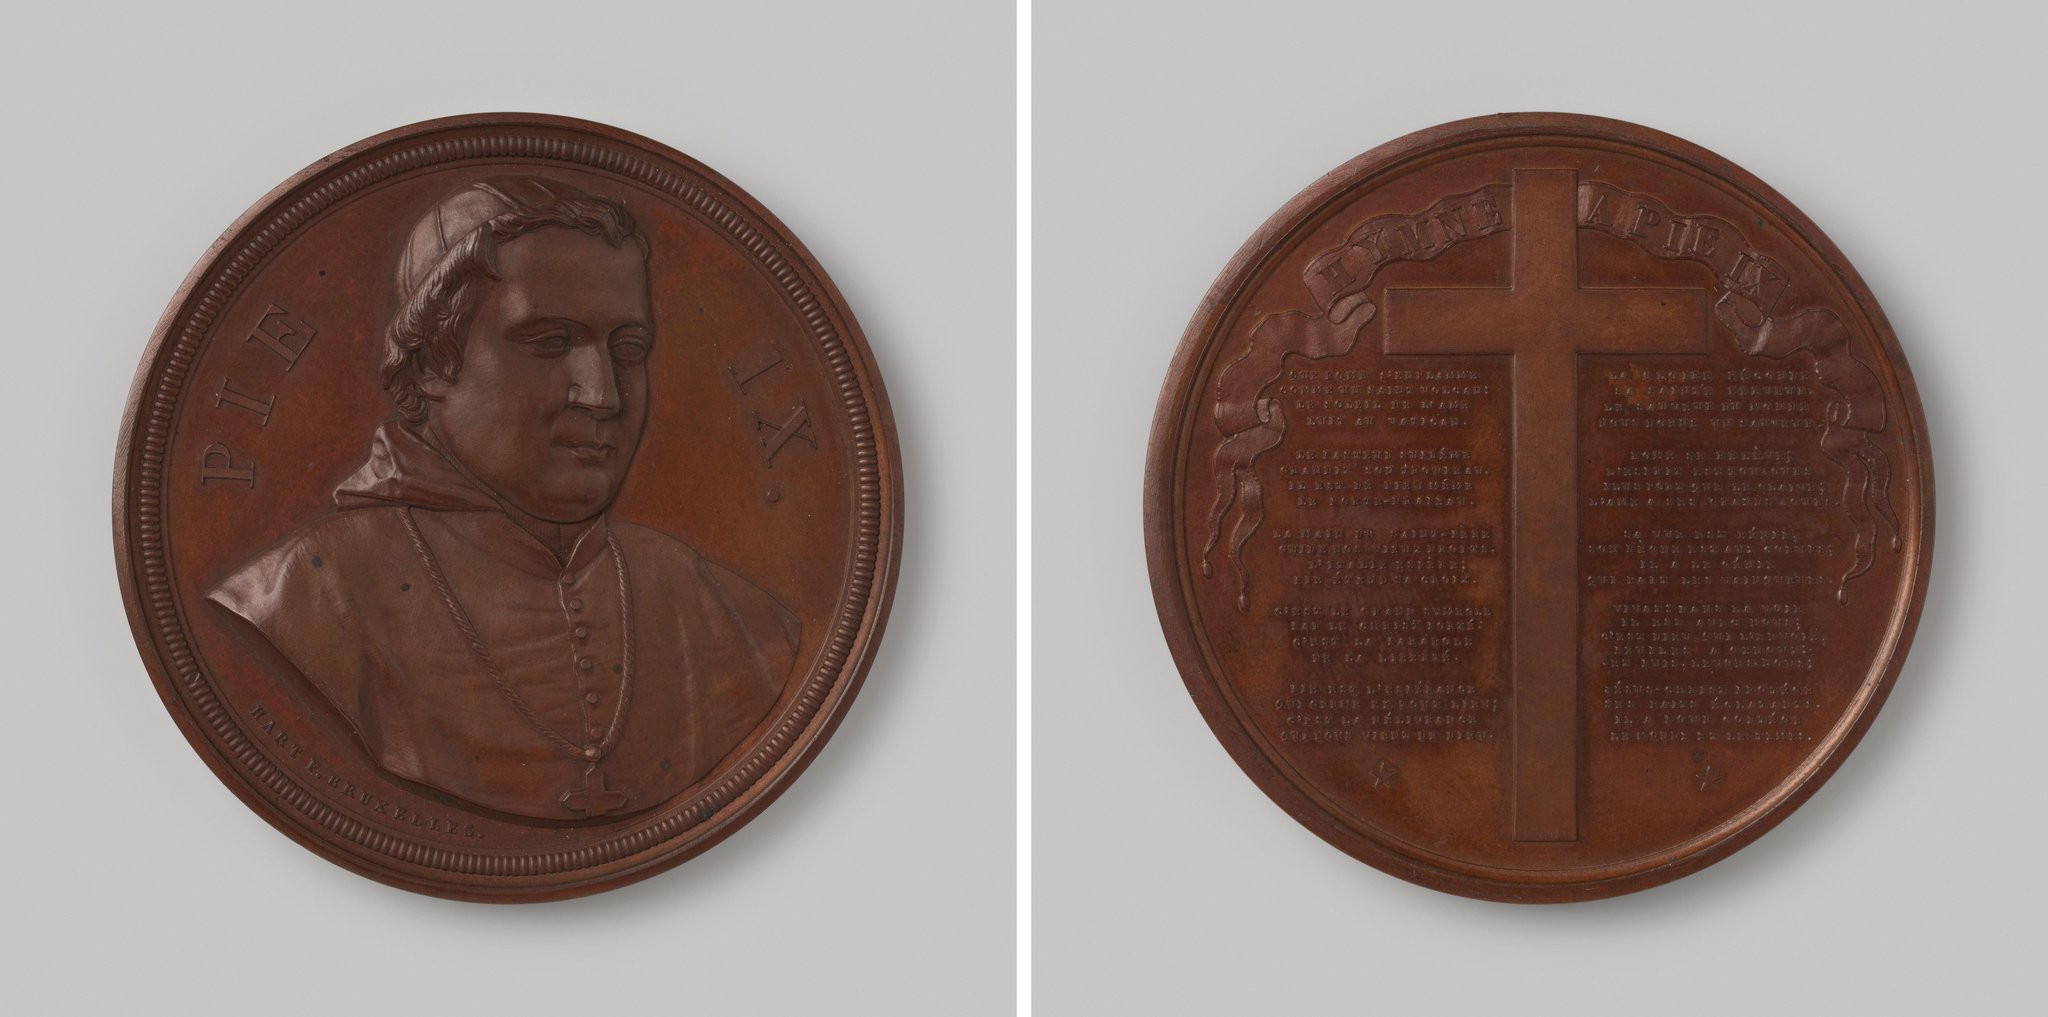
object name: history medal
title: Overlijden van Paus Pius IX 1878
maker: hart (stempelsnijder)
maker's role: die cutter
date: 1878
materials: bronze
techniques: striking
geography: brussels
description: Bronzen penning, op de voorzijde het borstbeeld van Pius half naar rechts, met omschrift, op de keerzijde een lang kruis met aan weerszijden in kleine letters vijf coupletten van een gedicht en bovenaan een banderol.